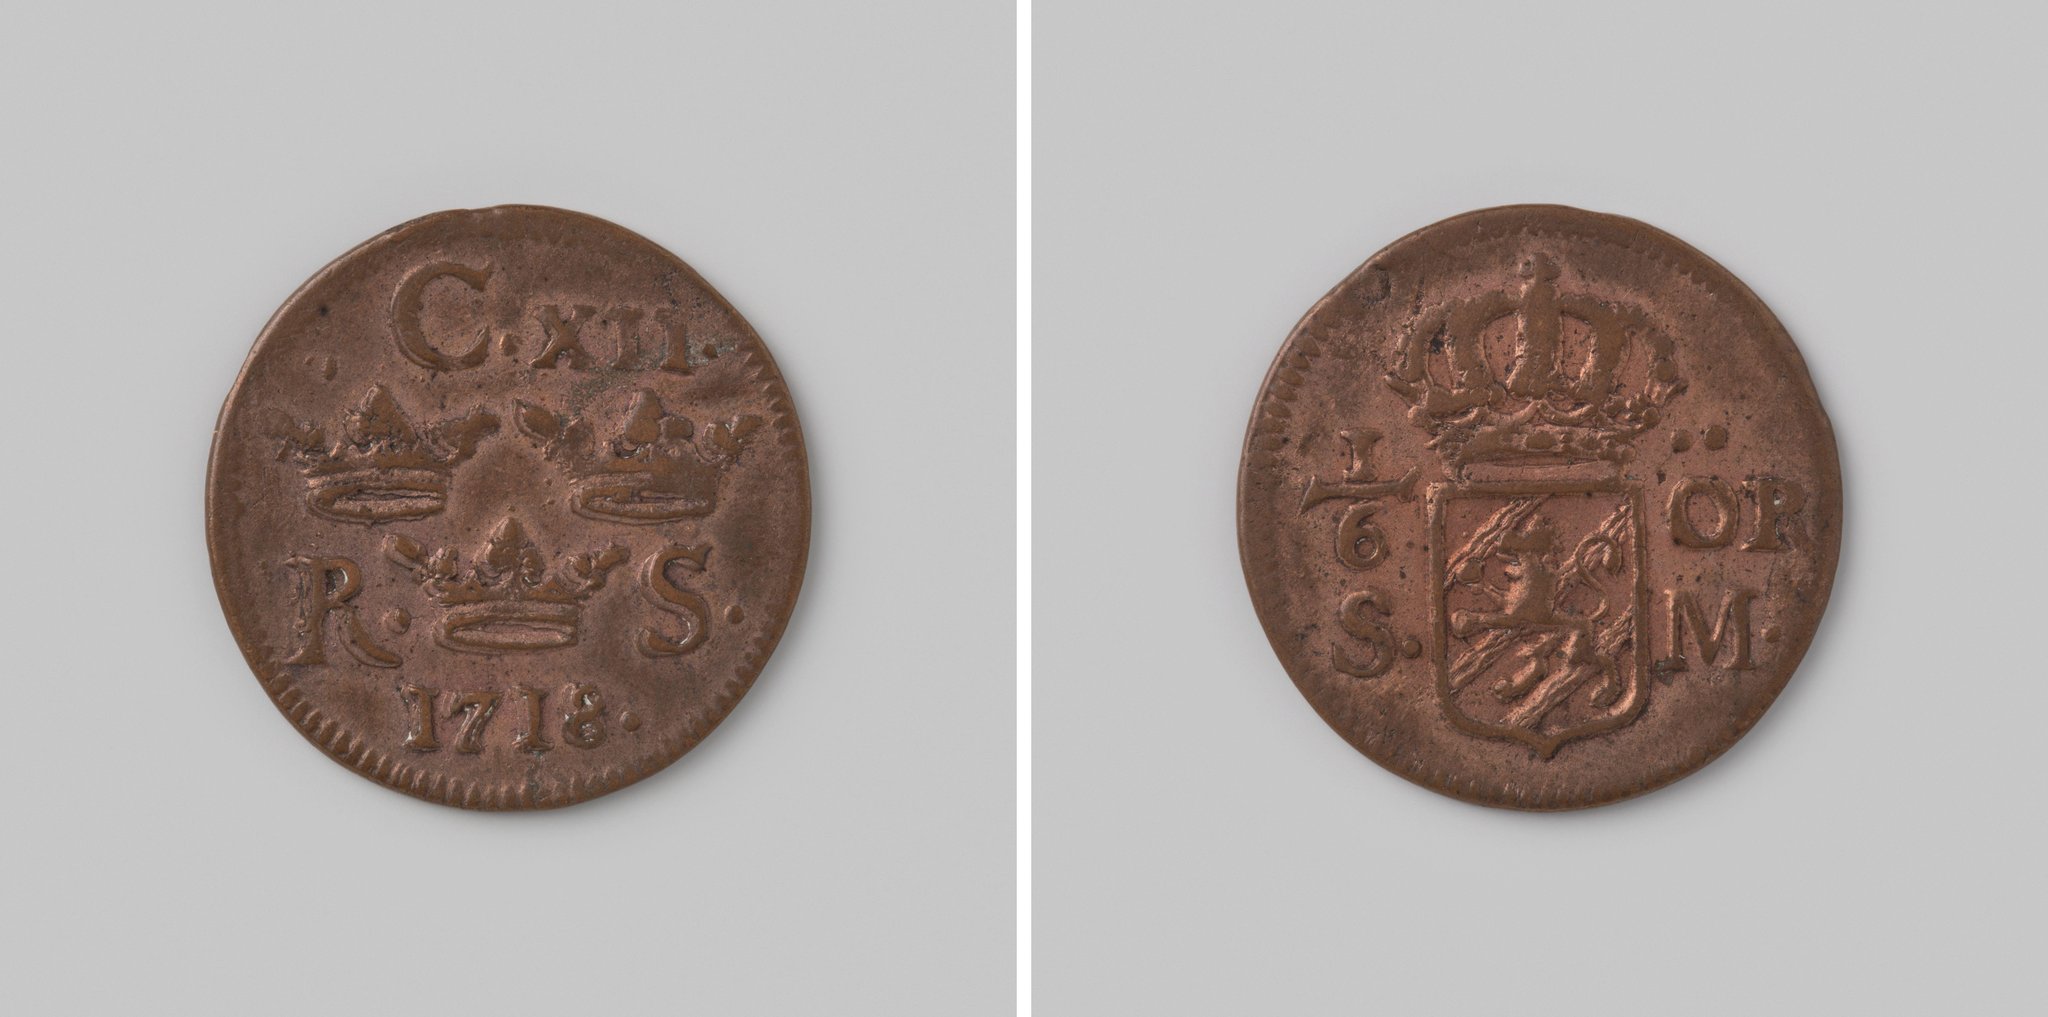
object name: coin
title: 1/6 öre Silver Mynt uit Zweden van Karel XII,1718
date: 1718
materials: copper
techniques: striking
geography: slot rörstrand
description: Koperen munt. Voorzijde: tussen drie kronen letters C-waarnaast XII-,S en R. Daaronder jaartal. Keerzijde: tussen waarde-aanduiding gekroond wapenschild. Gladde rand.